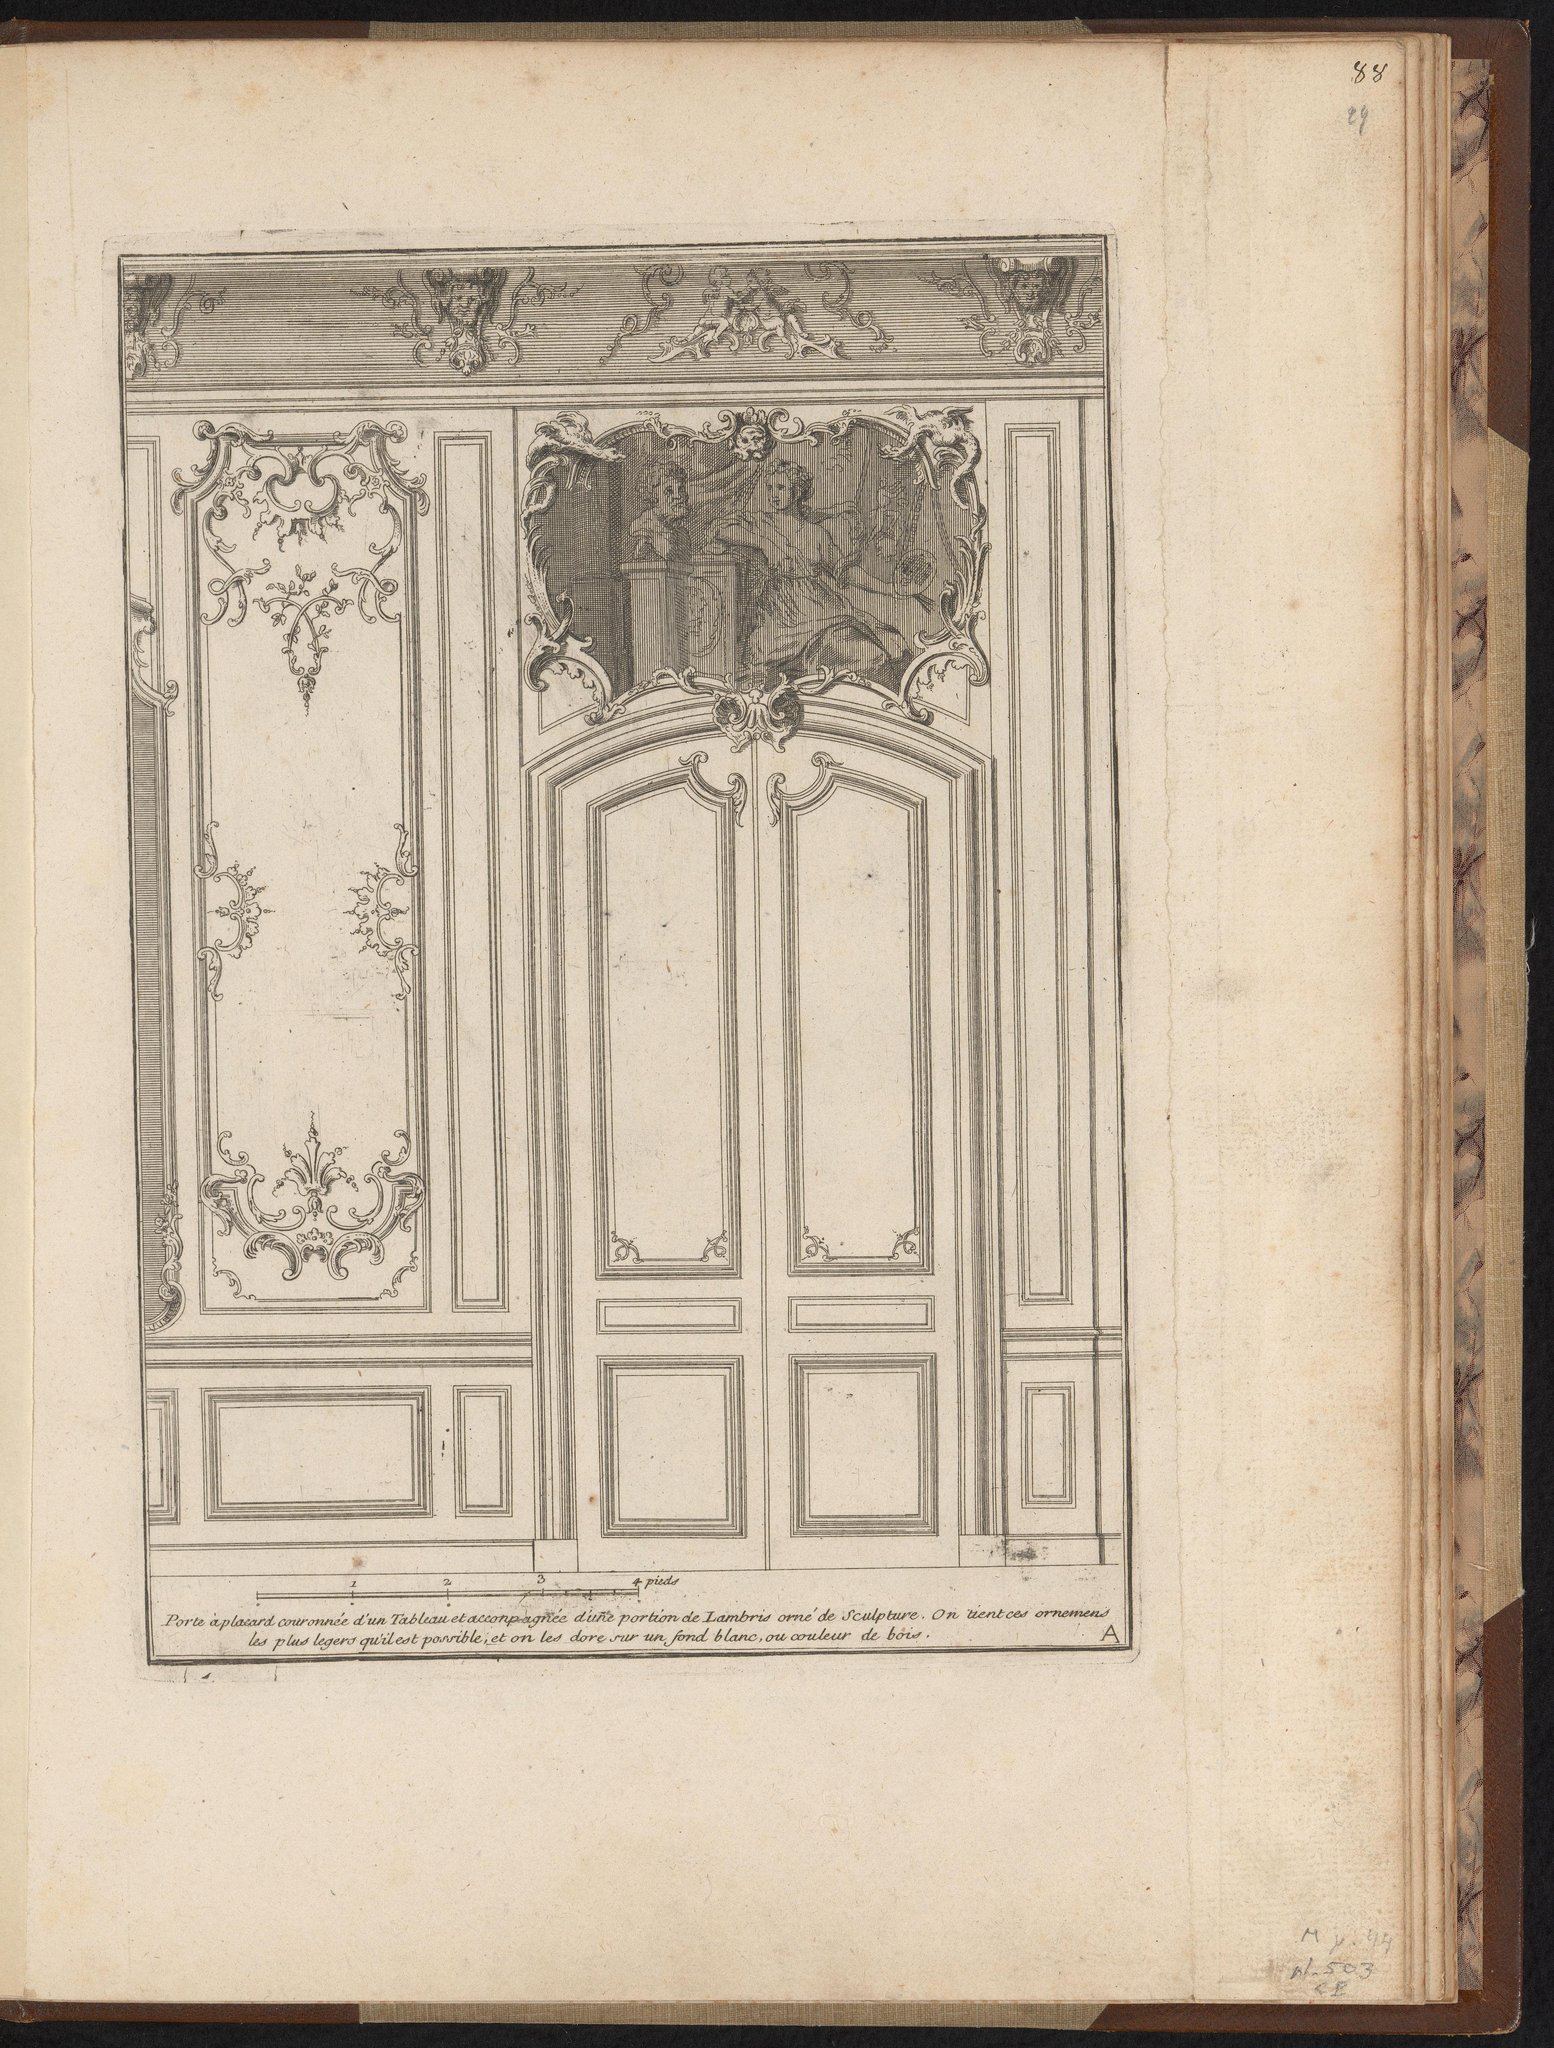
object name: album leaf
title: Porte à placard couronnée d'un tableau et accompagnée d'une portion de lambris orné de sculpture. On tient ces ornemens les plus legers qu'il est possible, et on les dore sur un fond blanc, ou couleur de bois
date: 1725-1750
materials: paper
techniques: etching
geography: paris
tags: ornaments ~ art, panelling, door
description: Deze prent maakt deel uit van een album.